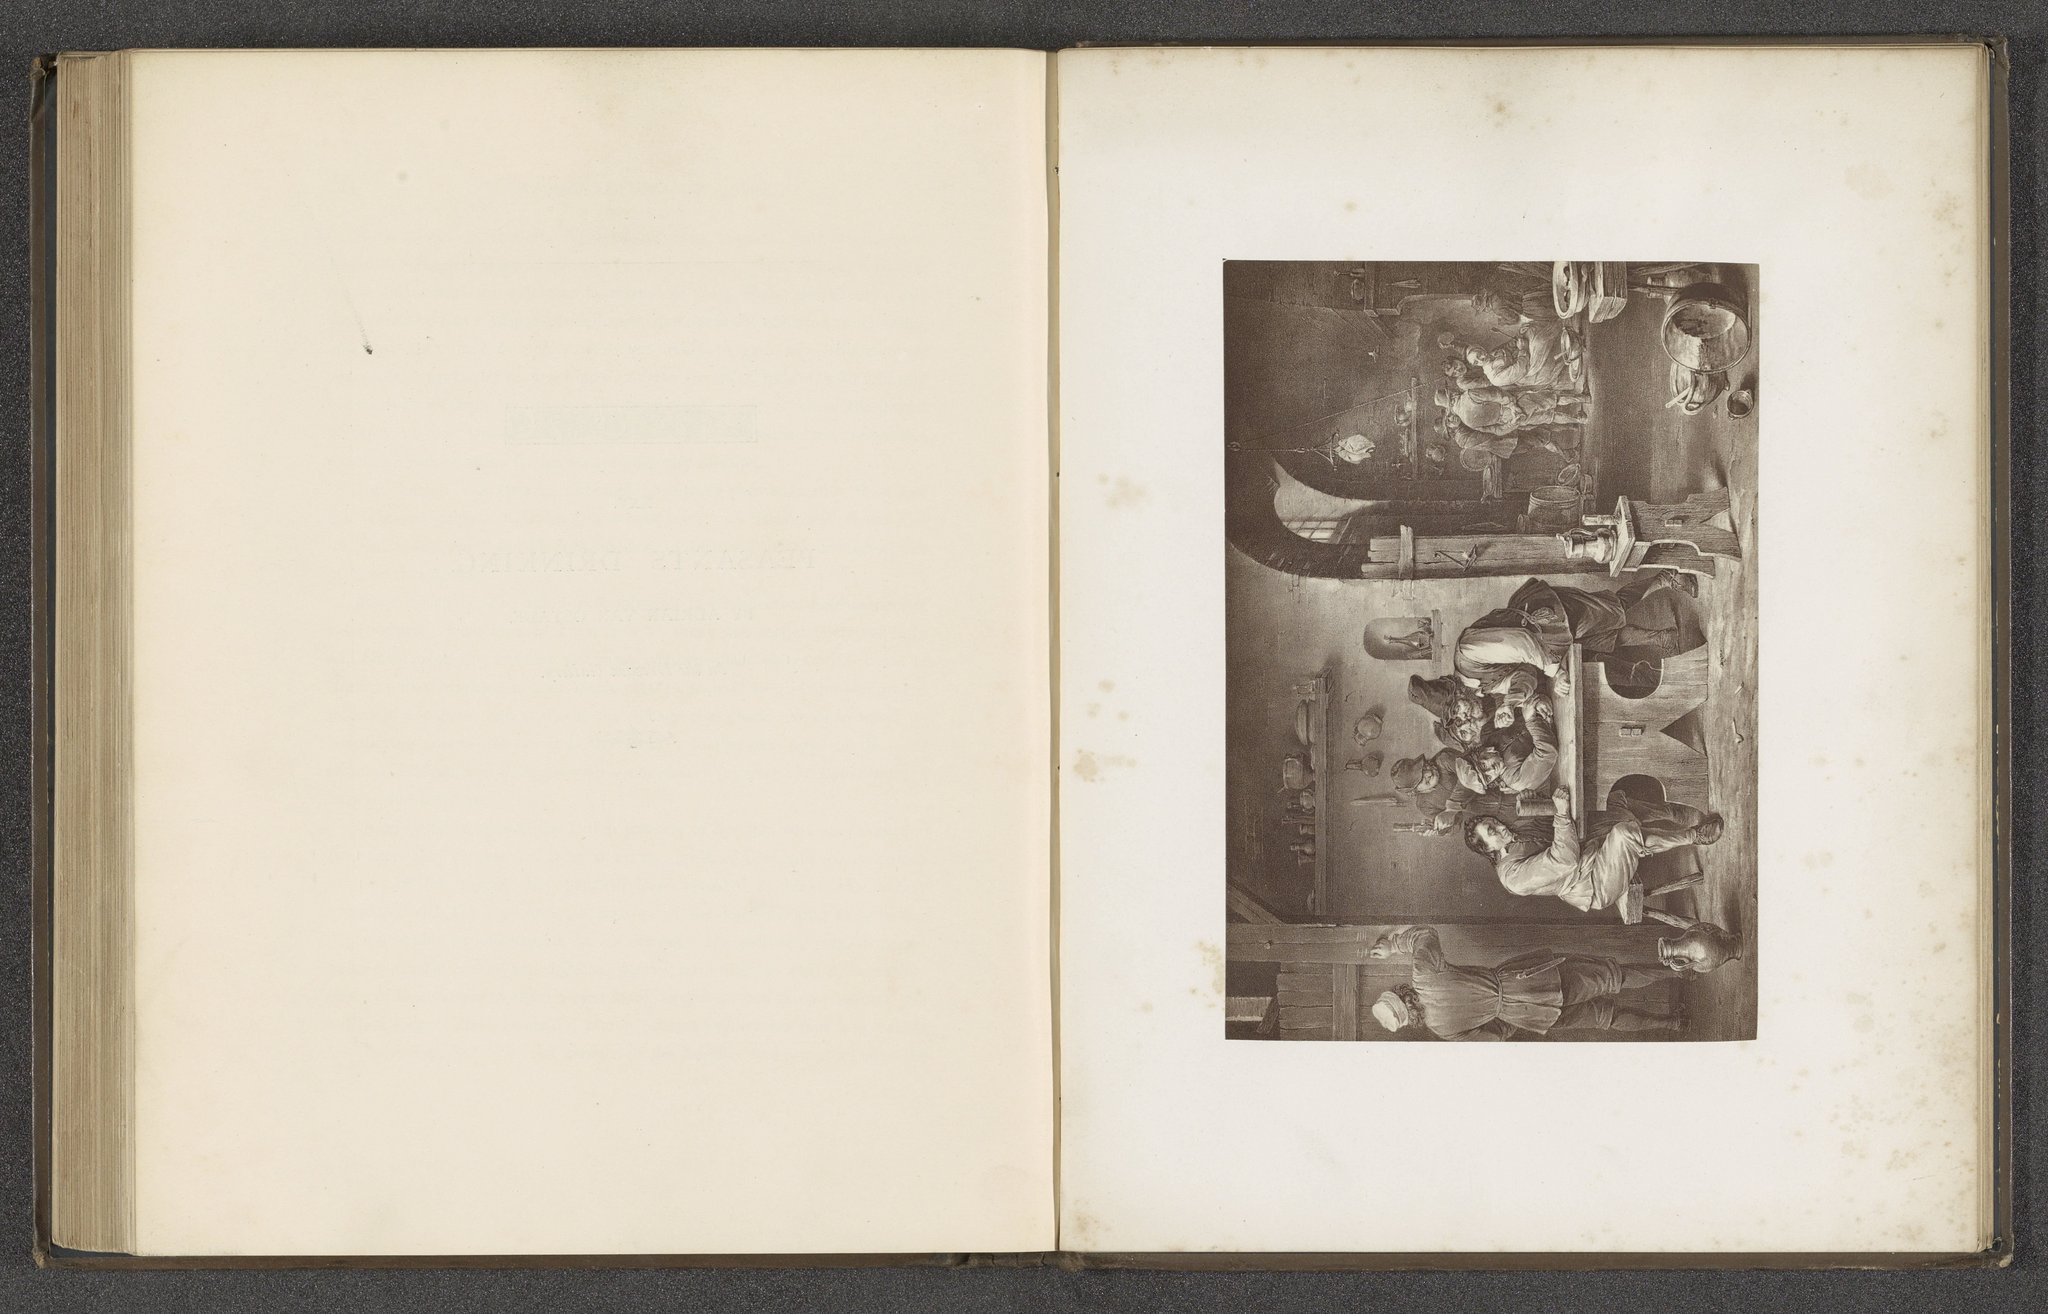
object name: photomechanical print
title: Fotoreproductie van een prent naar een schilderij, voorstellende een interieur van een herberg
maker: Anonymous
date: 1859-1869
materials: paper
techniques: woodburytype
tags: interior ~ representation of a building, hotel, hostelry, inn